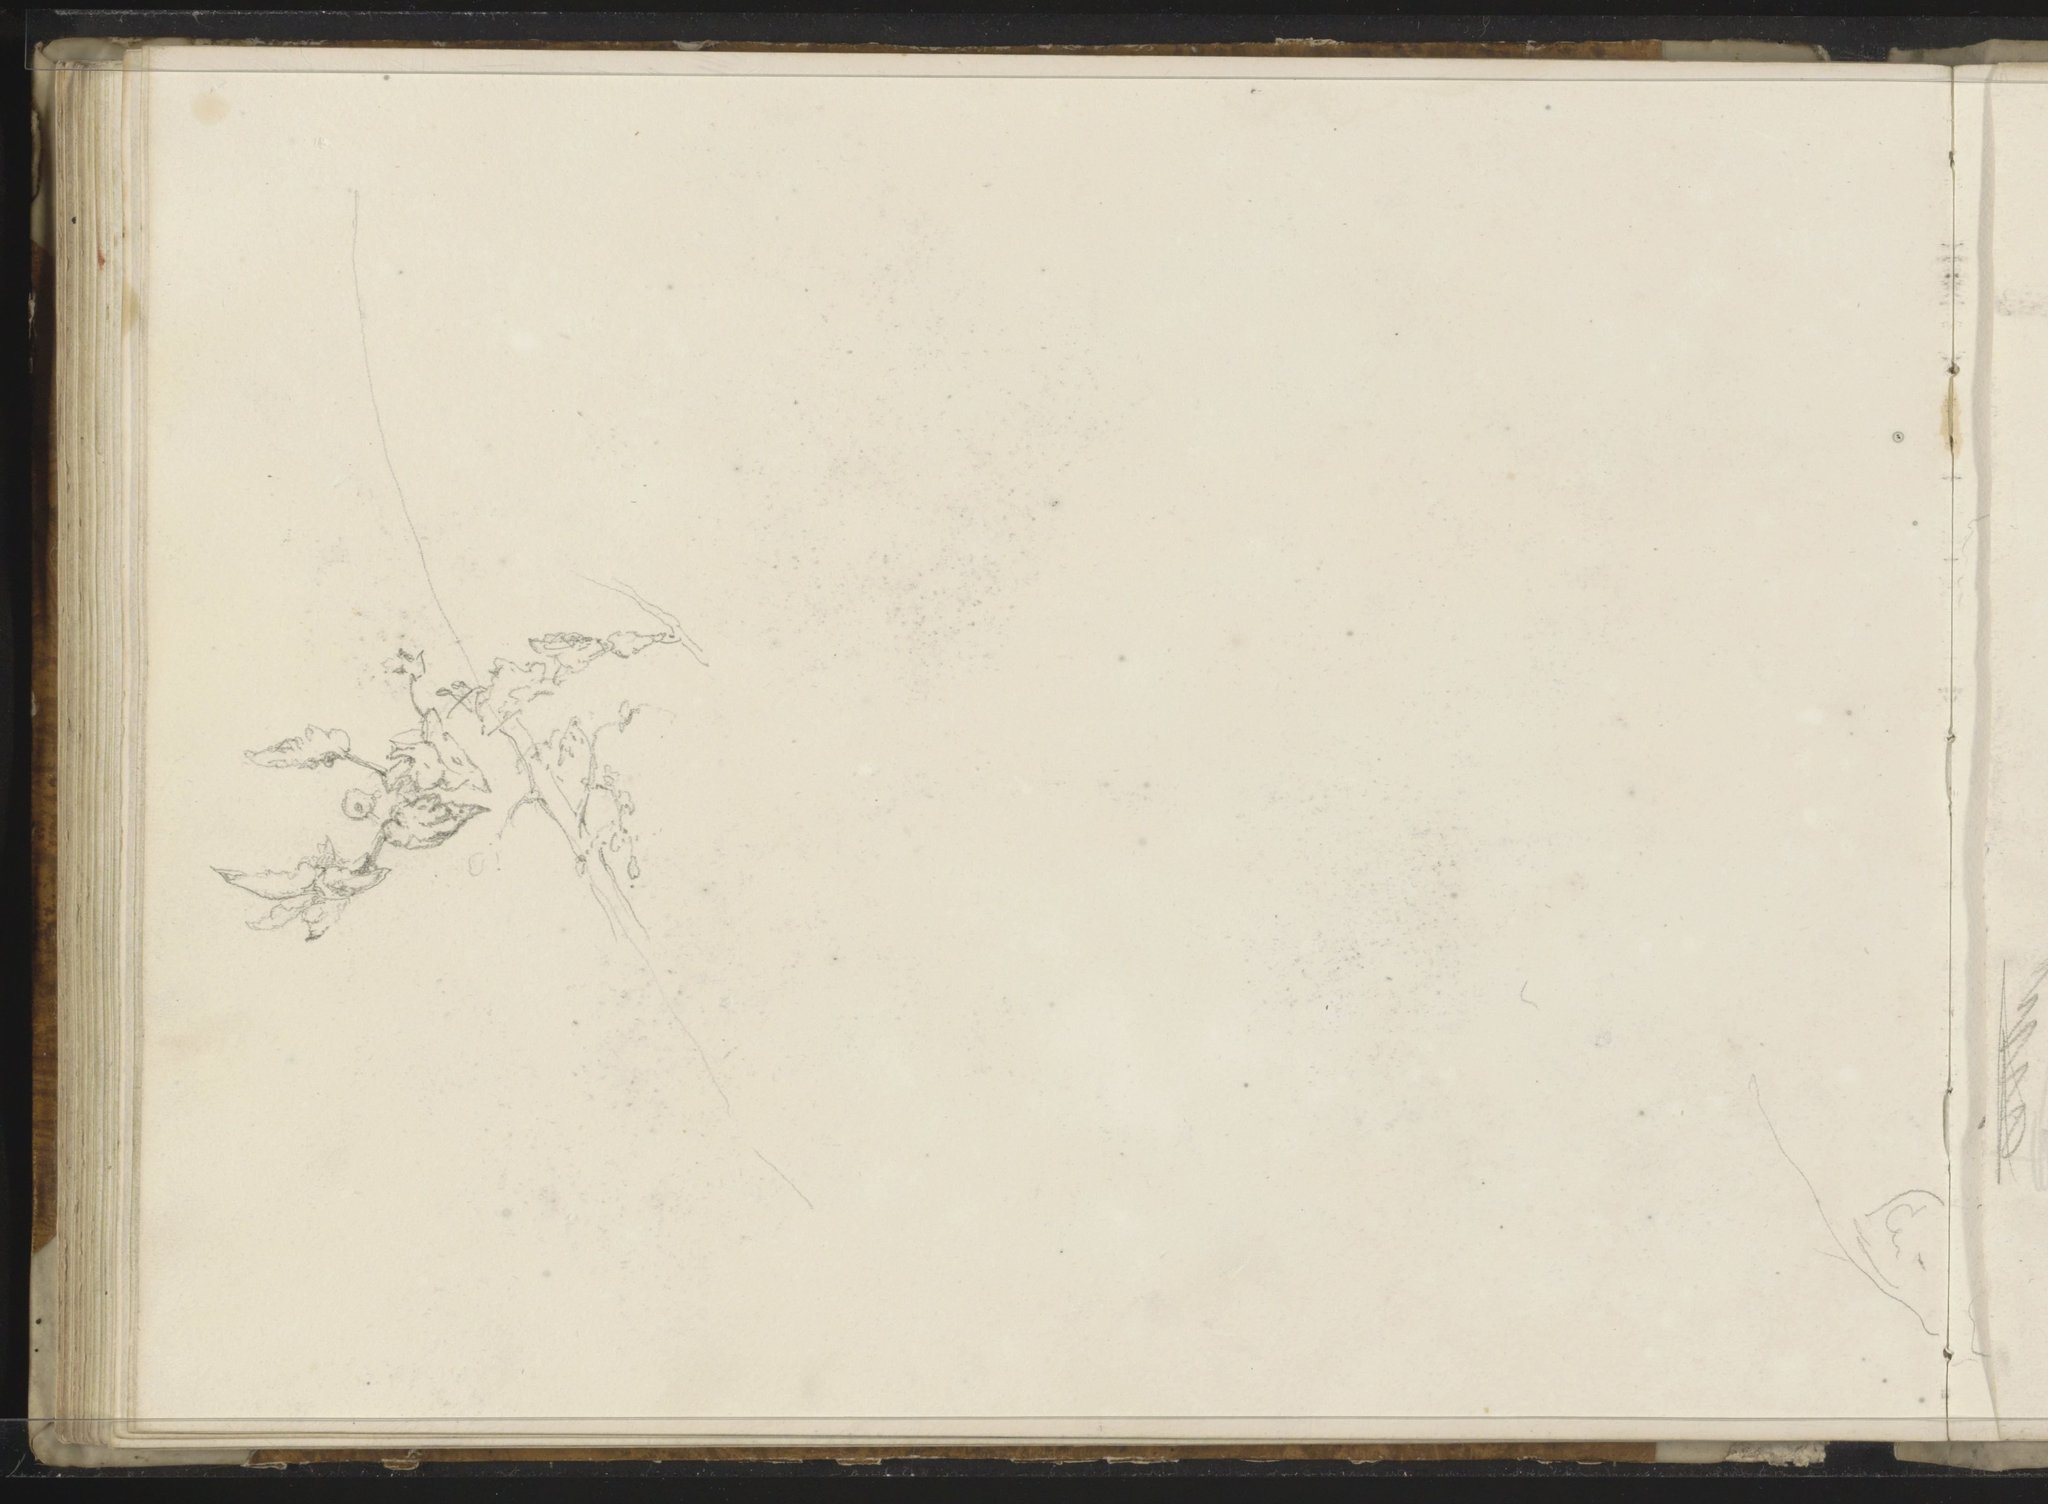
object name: sketchbook leaf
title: Bloeiende tak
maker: maria vos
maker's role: draughtsman, painter, print maker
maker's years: 1824-1906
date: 1834-1906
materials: paper, pencil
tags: trees (+ branch, stick)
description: Blad 34 verso uit een schetsboek met 39 bladen.